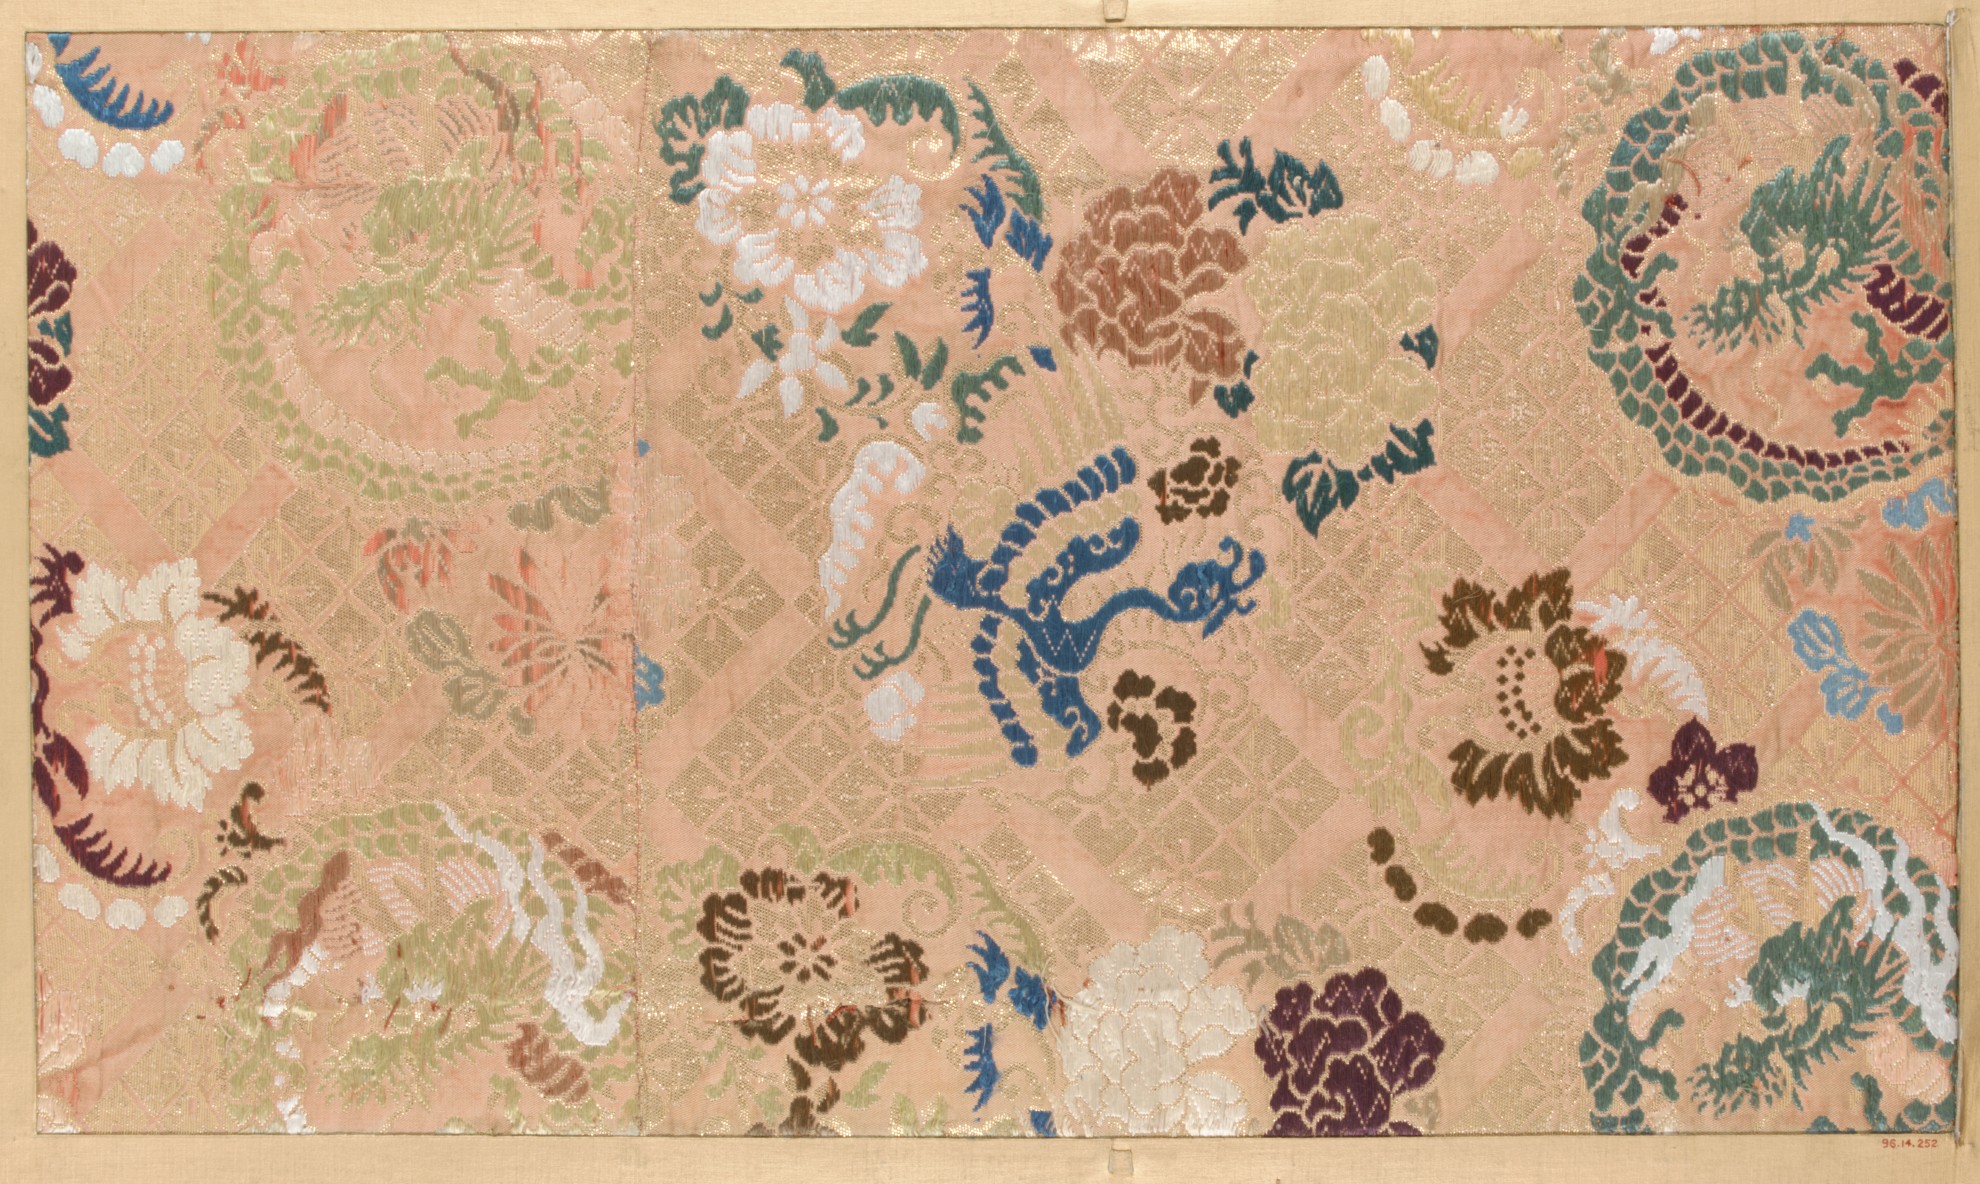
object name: piece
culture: japanese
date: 1701-1900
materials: silk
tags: dragons